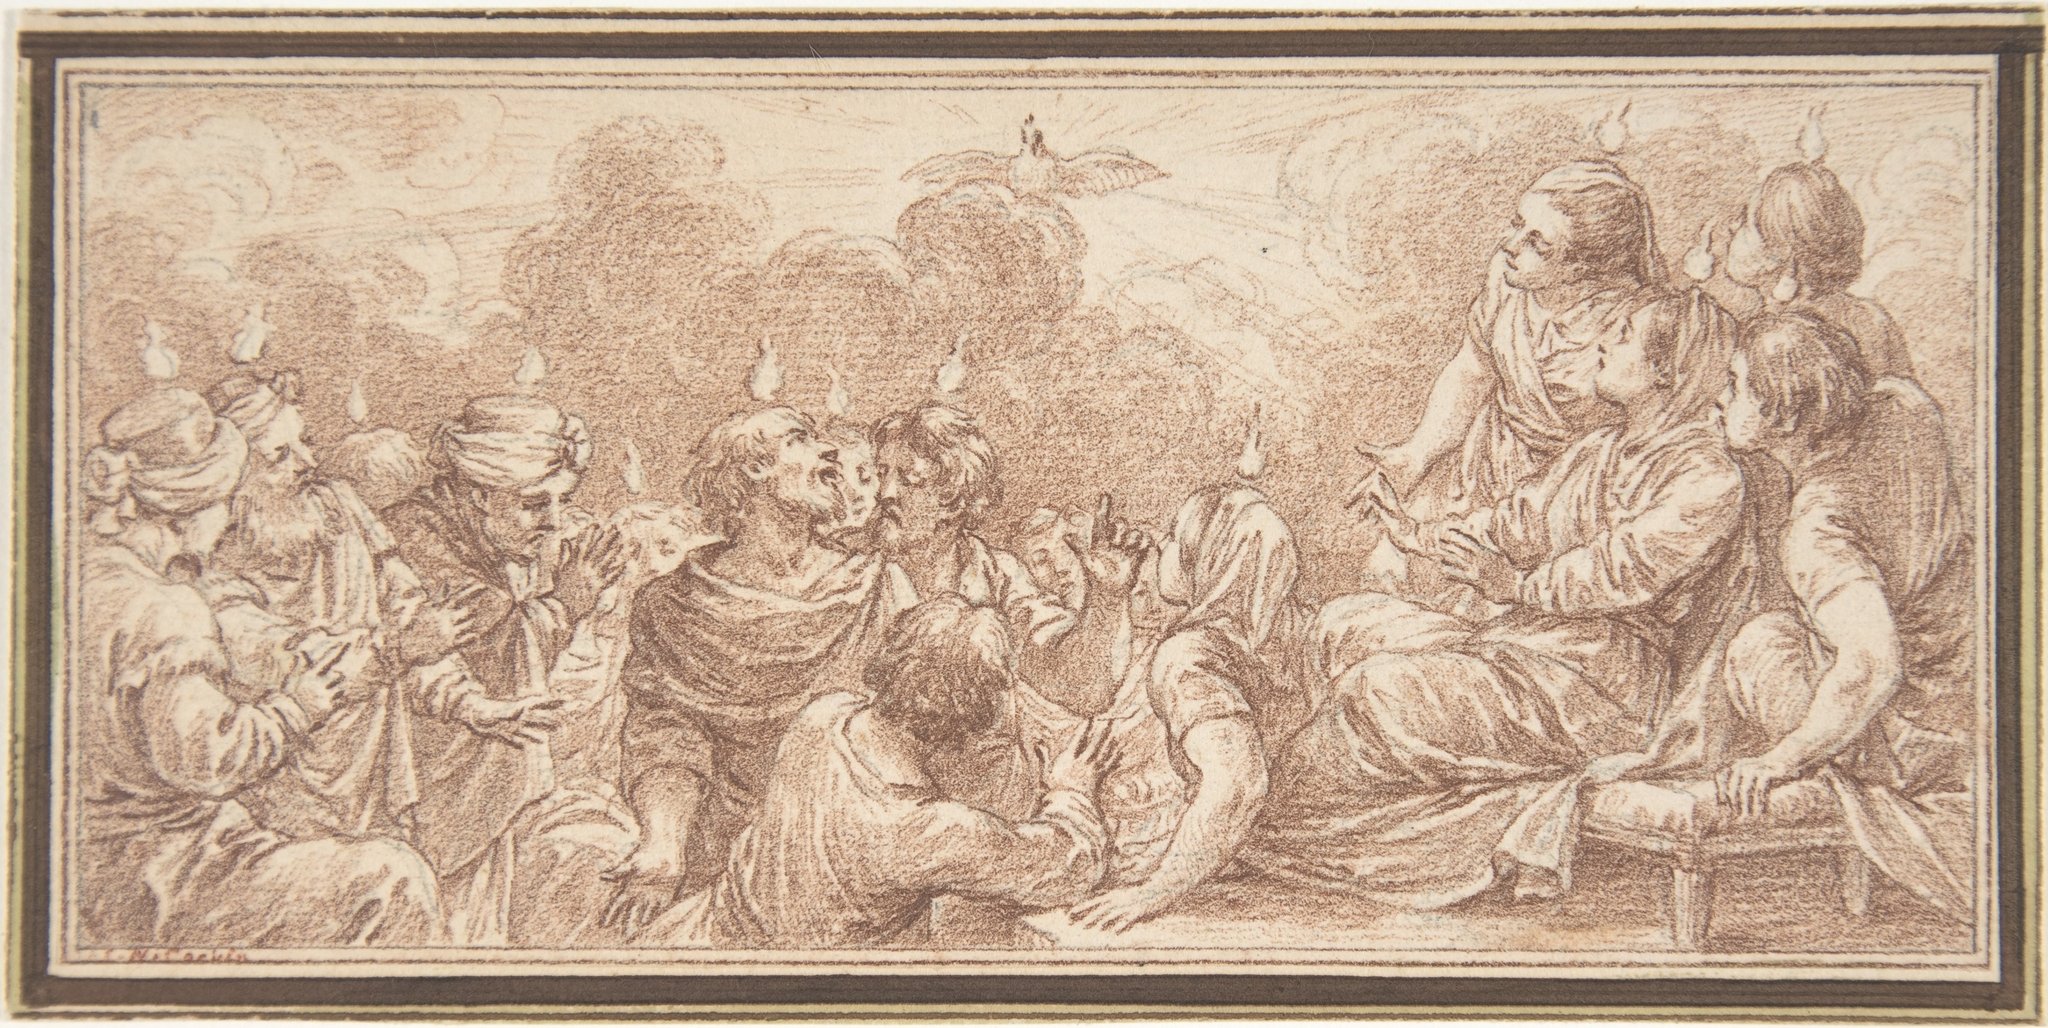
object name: drawing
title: The Coming of the Holy Spirit at Pentecost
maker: charles nicolas cochin ii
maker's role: artist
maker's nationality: french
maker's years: 1715-1790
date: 1730-1790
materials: chalk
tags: birds,men,women,pentecost